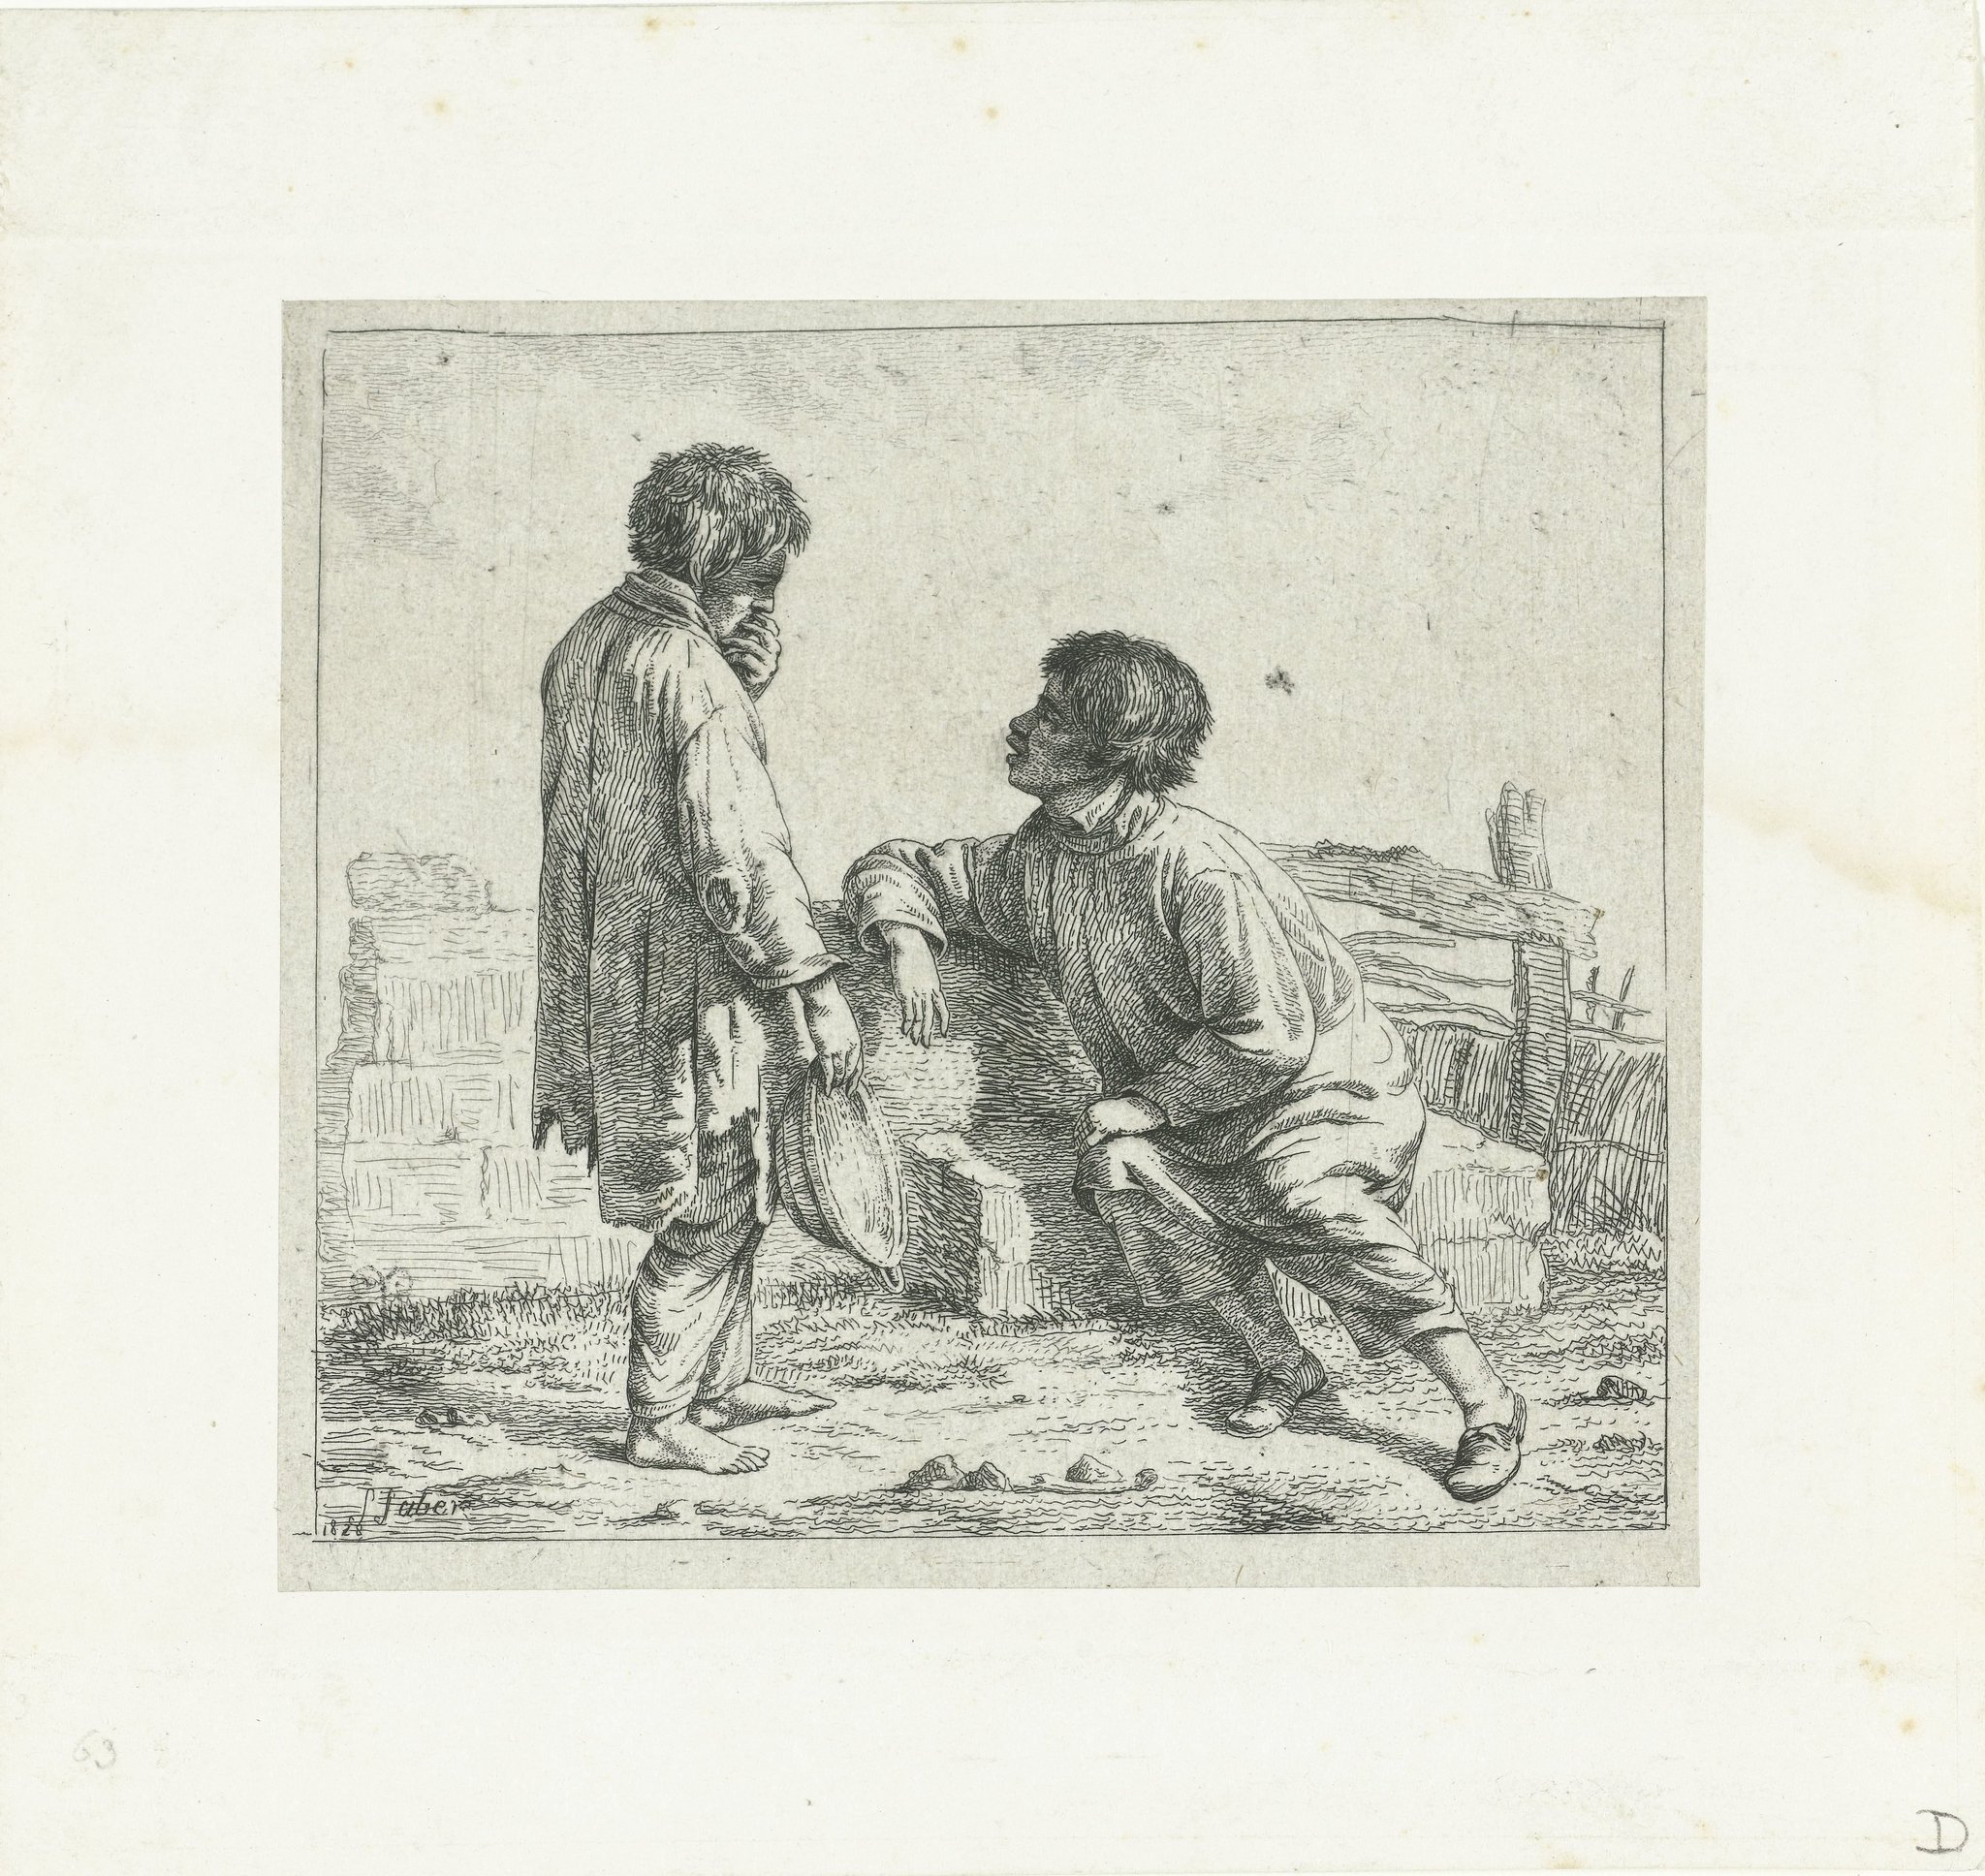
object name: print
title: Twee pratende mannen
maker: frédéric théodore faber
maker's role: print maker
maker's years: 1782-1844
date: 1828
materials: paper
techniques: etching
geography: brussels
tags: address, talk, lecture (~ meeting) - aa - in the open air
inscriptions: collector's mark: Lugt 1485, collector's mark: Lugt 2228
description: Een zittende man in gesprek met een staande man met een schaal in zijn handen.